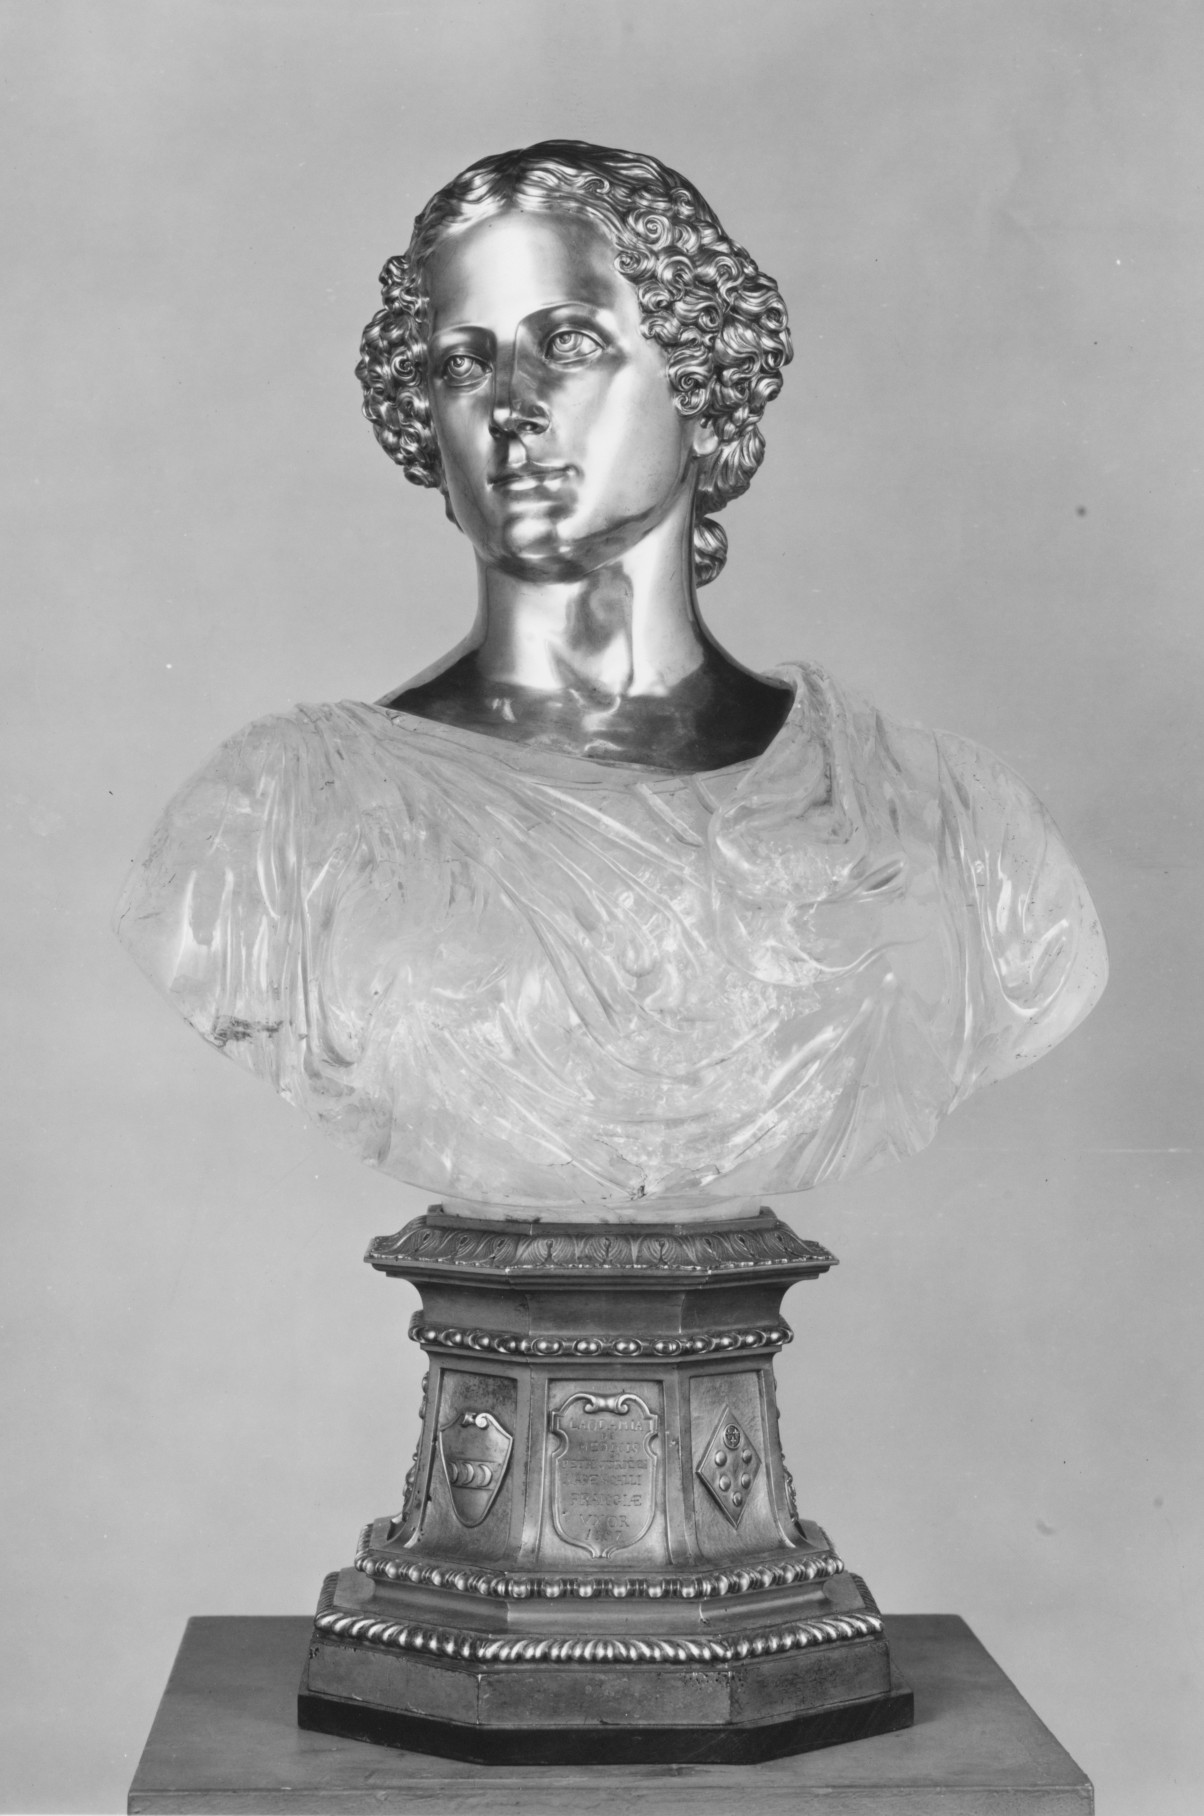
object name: bust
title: Laudomia de' Medici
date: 1801-1833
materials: crystal, silver, silver gilt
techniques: casting, repoussé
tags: portraits,women